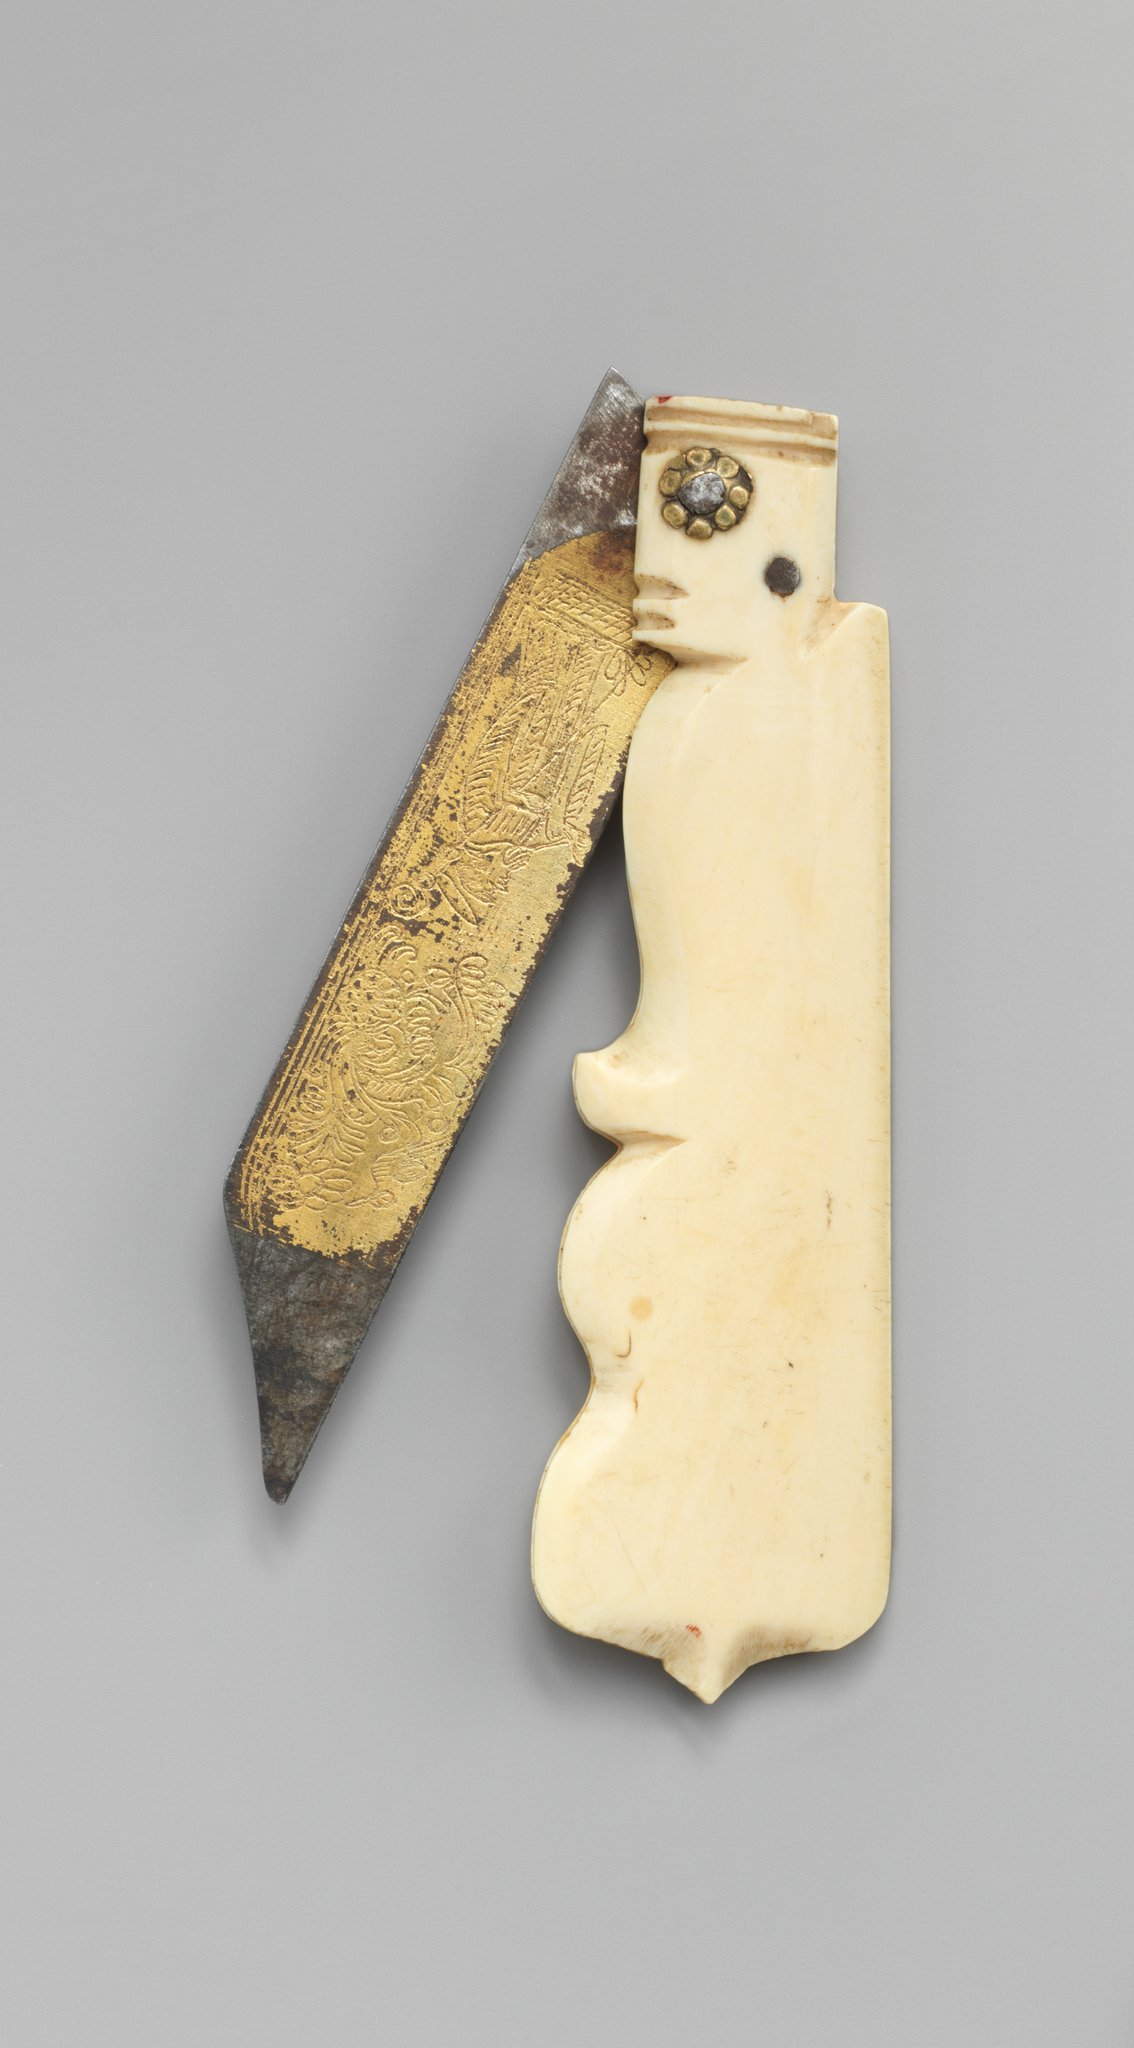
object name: knife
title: Folding Knife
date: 1601-1800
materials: ivory, steel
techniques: gilding